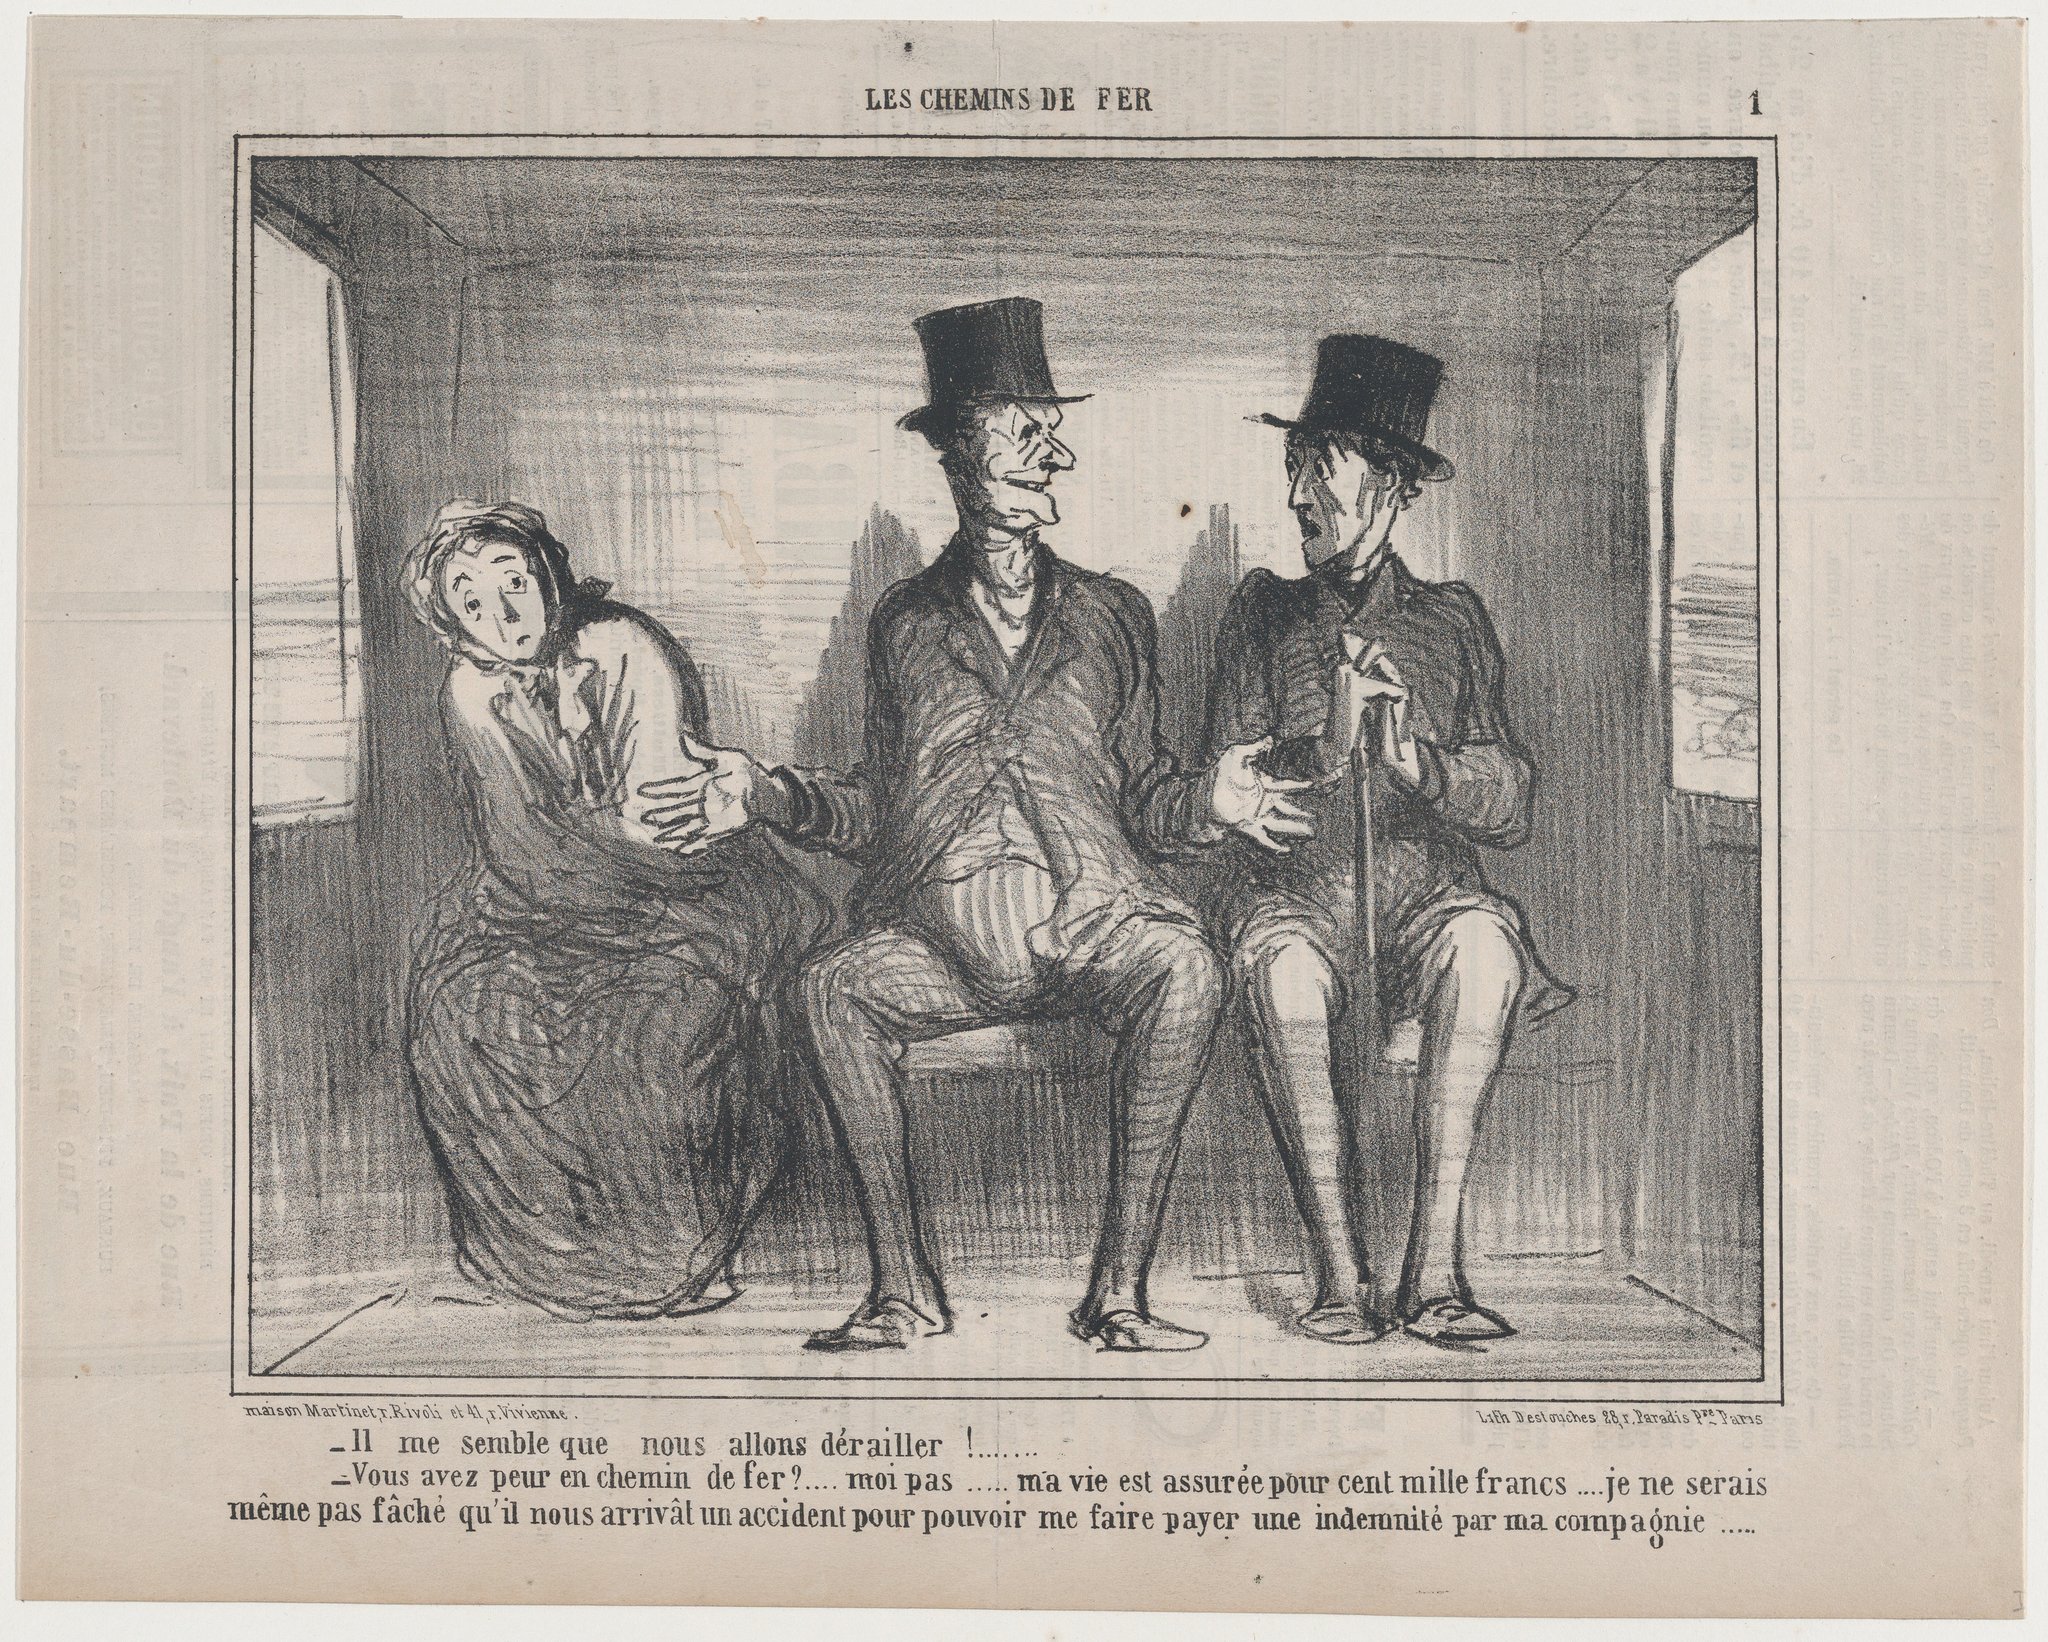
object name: print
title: Il me semble que nous allons dérailler..., from Les Chemins de Fer, published in Le Charivari, December 19, 1857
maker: honoré daumier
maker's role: artist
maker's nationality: french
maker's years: 1808-1879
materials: paper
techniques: lithograph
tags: men,women